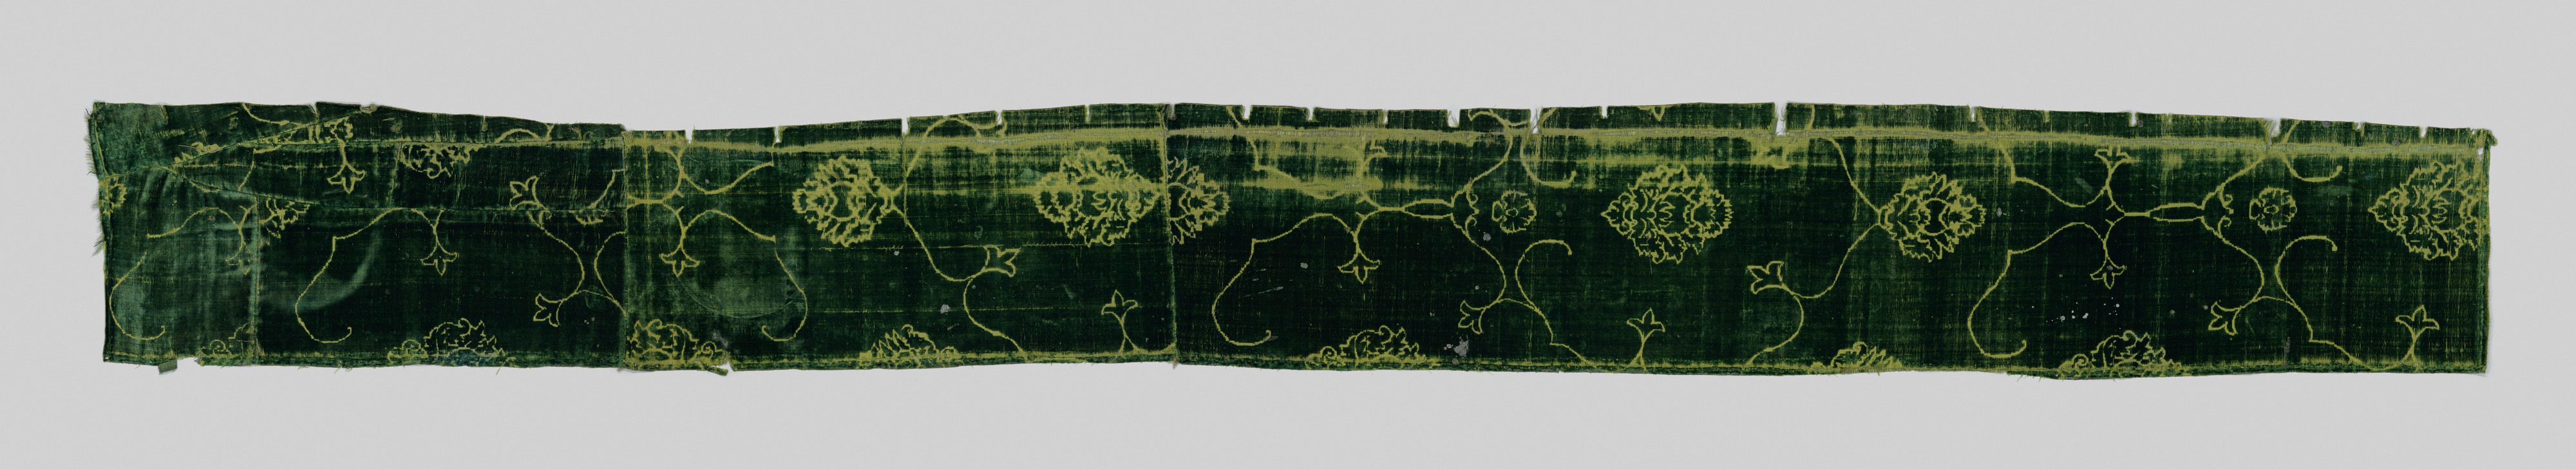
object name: textile fragment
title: Fragment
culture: italian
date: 1401-1500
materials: silk